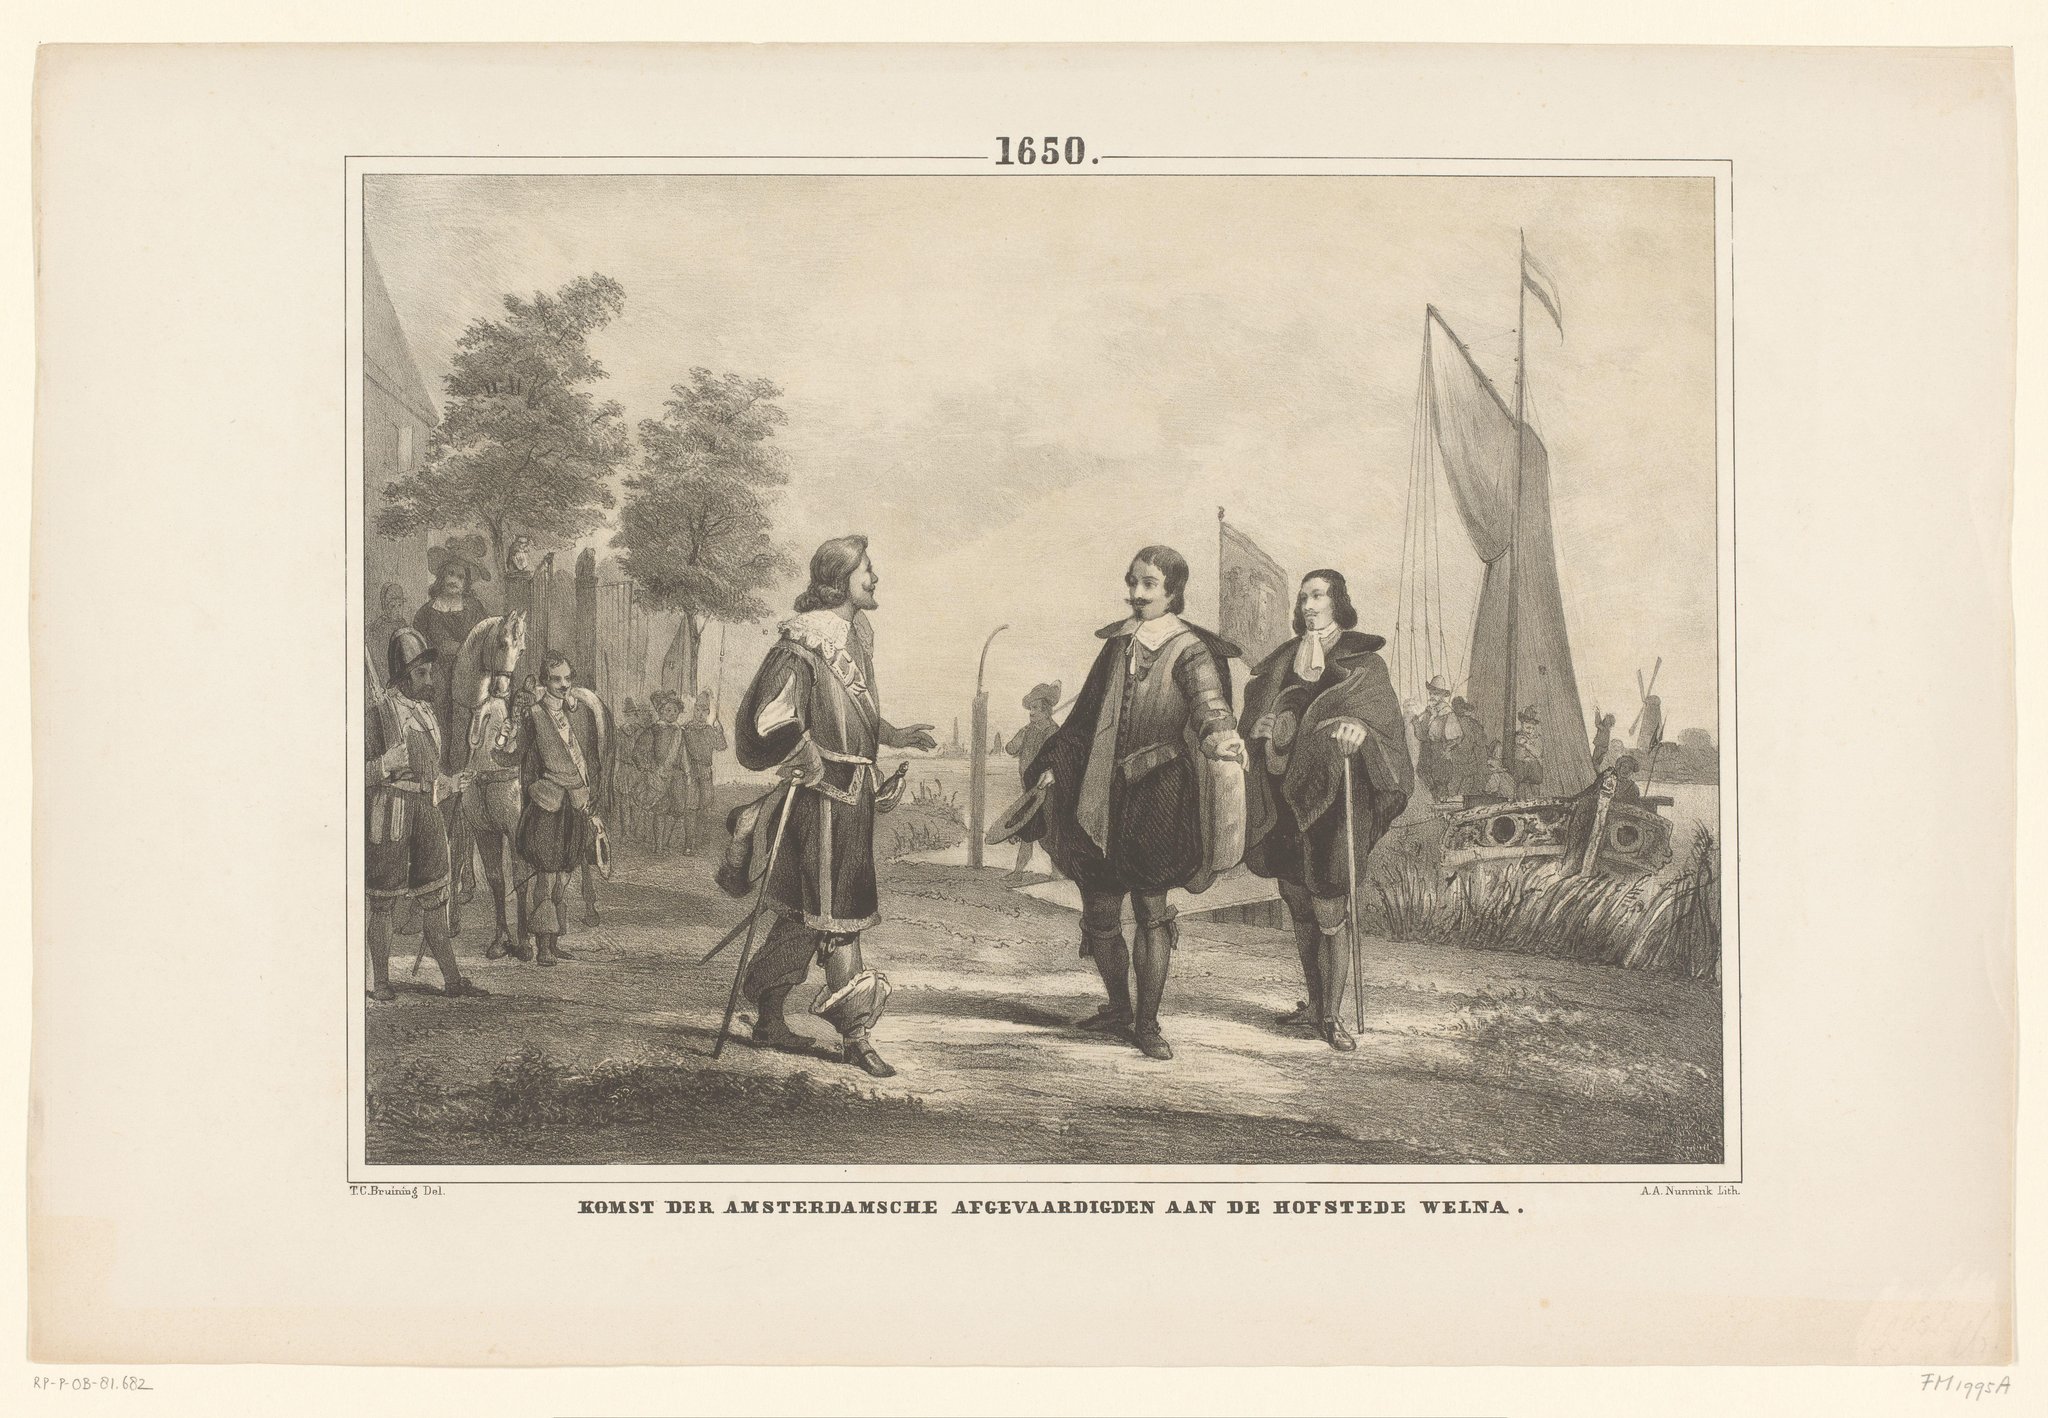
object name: print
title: 1650 / Komst der Amsterdamsche afgevaardigden aan de hofstede Welna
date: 1853-1855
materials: paper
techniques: tone lithography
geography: netherlands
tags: arnhem, william ii (prince of orange)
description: Illustratie voor: J.H. Eichman & H. Altmann, Vaderlandsche historieplaten voor scholen en huisgezinnen, Leiden, 1855. Dit nummer is een door het RPK toegevoegd nummer en staat niet in Frederik Muller, het werk waar de prent voor is gemaakt of uit afkomstig is, staat wel vermeld in Frederik Muller.